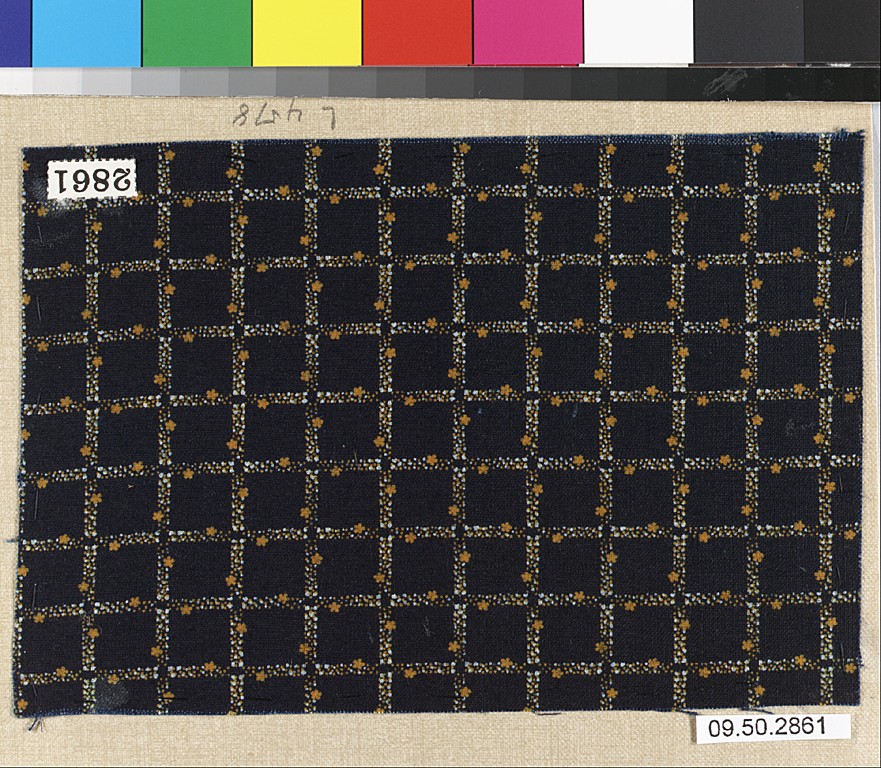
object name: piece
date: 1801-1900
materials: cotton